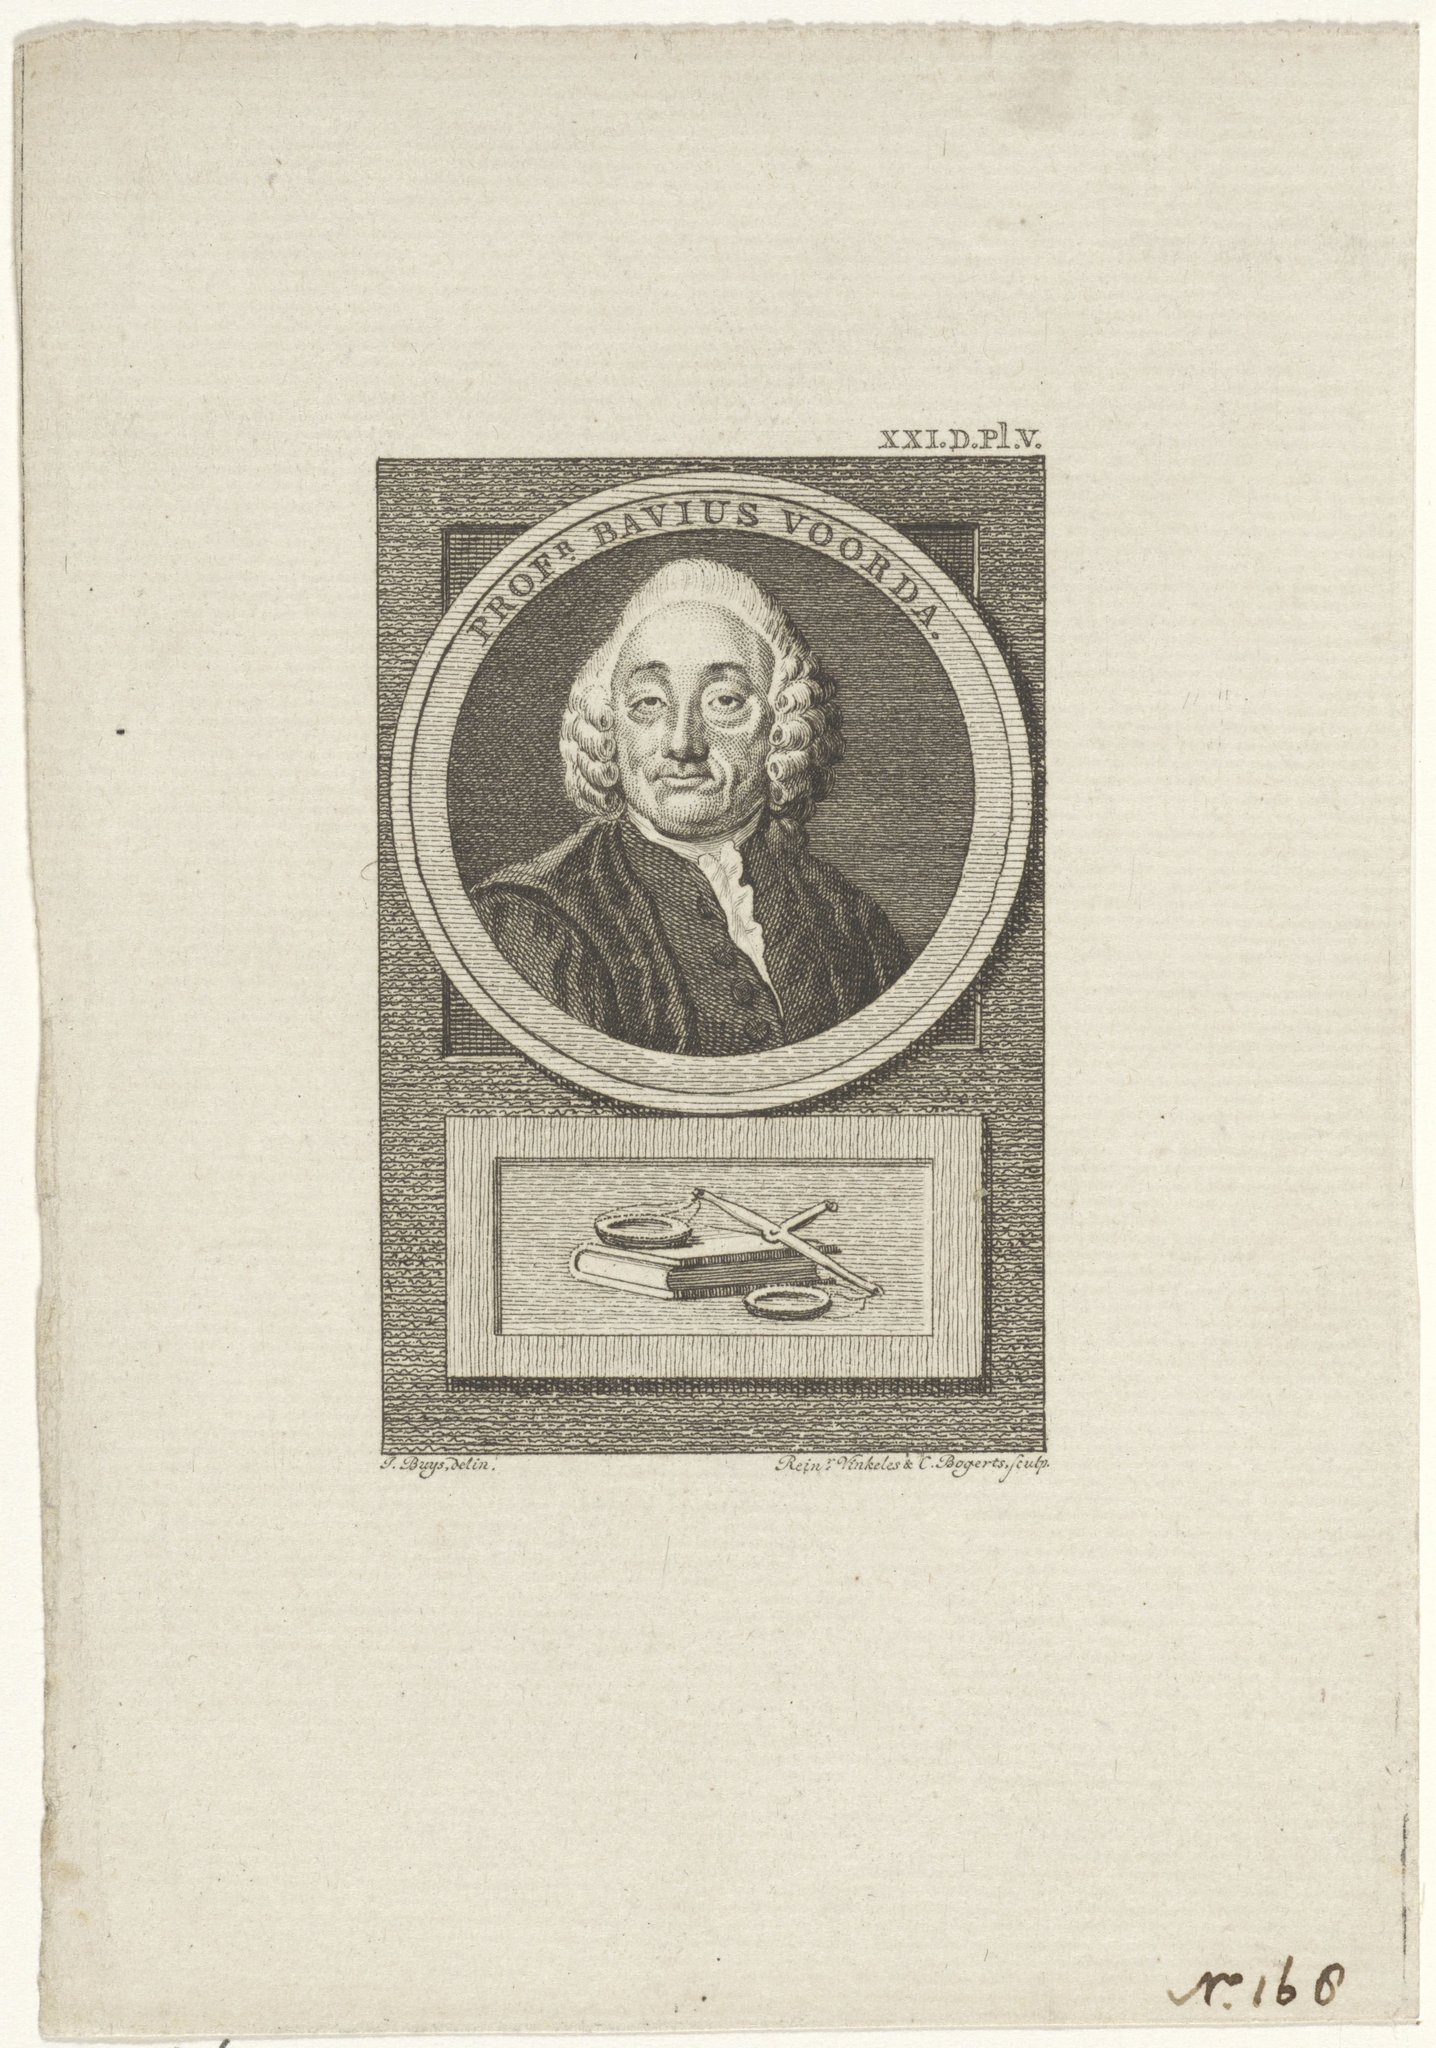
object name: print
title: Portret van Bavius Voorda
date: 1783-1795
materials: paper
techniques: engraving, etching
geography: amsterdam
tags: symbols and allegories of jurisprudence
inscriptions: number: ‘No. 168’, collector's mark: Lugt 2228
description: Prent gebruikt in: Fokke, Jan. Geschiedenissen der Vereenigde Nederlanden voor de vaderlandsche jeugd Ie-XXVste deel. Amsterdam: Johannes Allart, 1783-1795. Deel XXI.